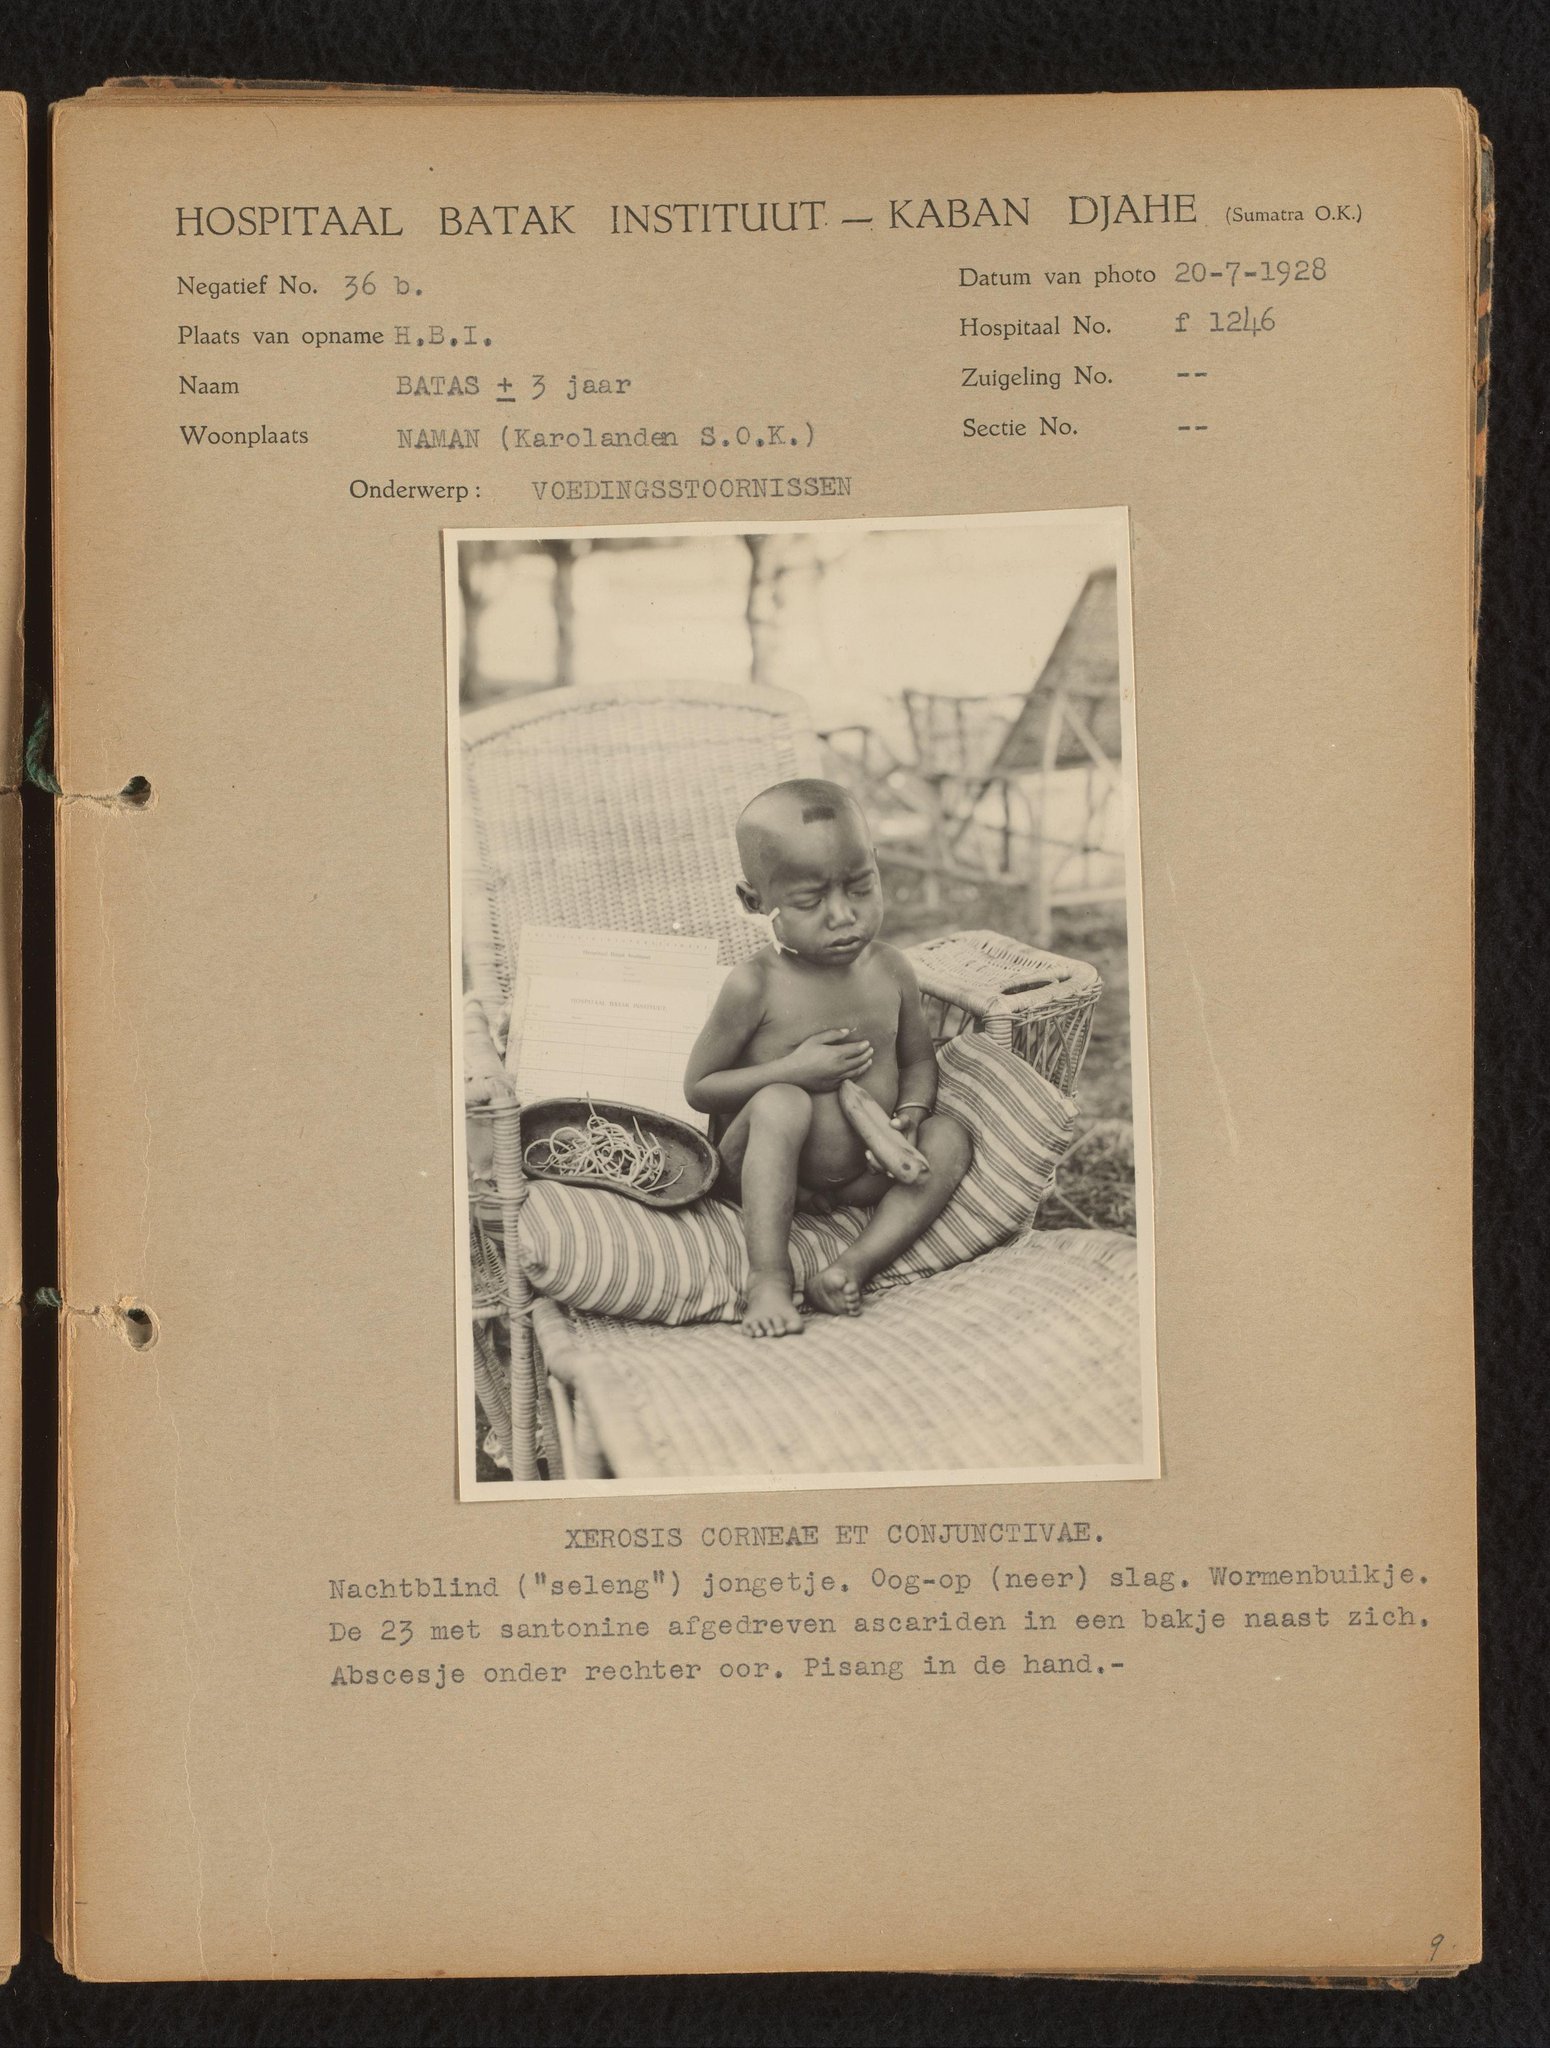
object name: photograph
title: Kind met voedingsstoornissen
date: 1928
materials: cardboard, photographic support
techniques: gelatin silver print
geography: kabanjahe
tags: colonial system, patient, sick person, sumatra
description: Medische foto van een kind patiënt genaamd Batas van ca. 3 jaar met aandoeningen die het gevolg zijn van gebrekkige voeding. Datum foto: 20 juli 1928. Foto geplakt op voorgedrukt kartonnen blad ingebonden in het fotoalbum over het Hospitaal Batak Instituut te Kabanjaheh op Sumatra in de jaren 1926-1929.